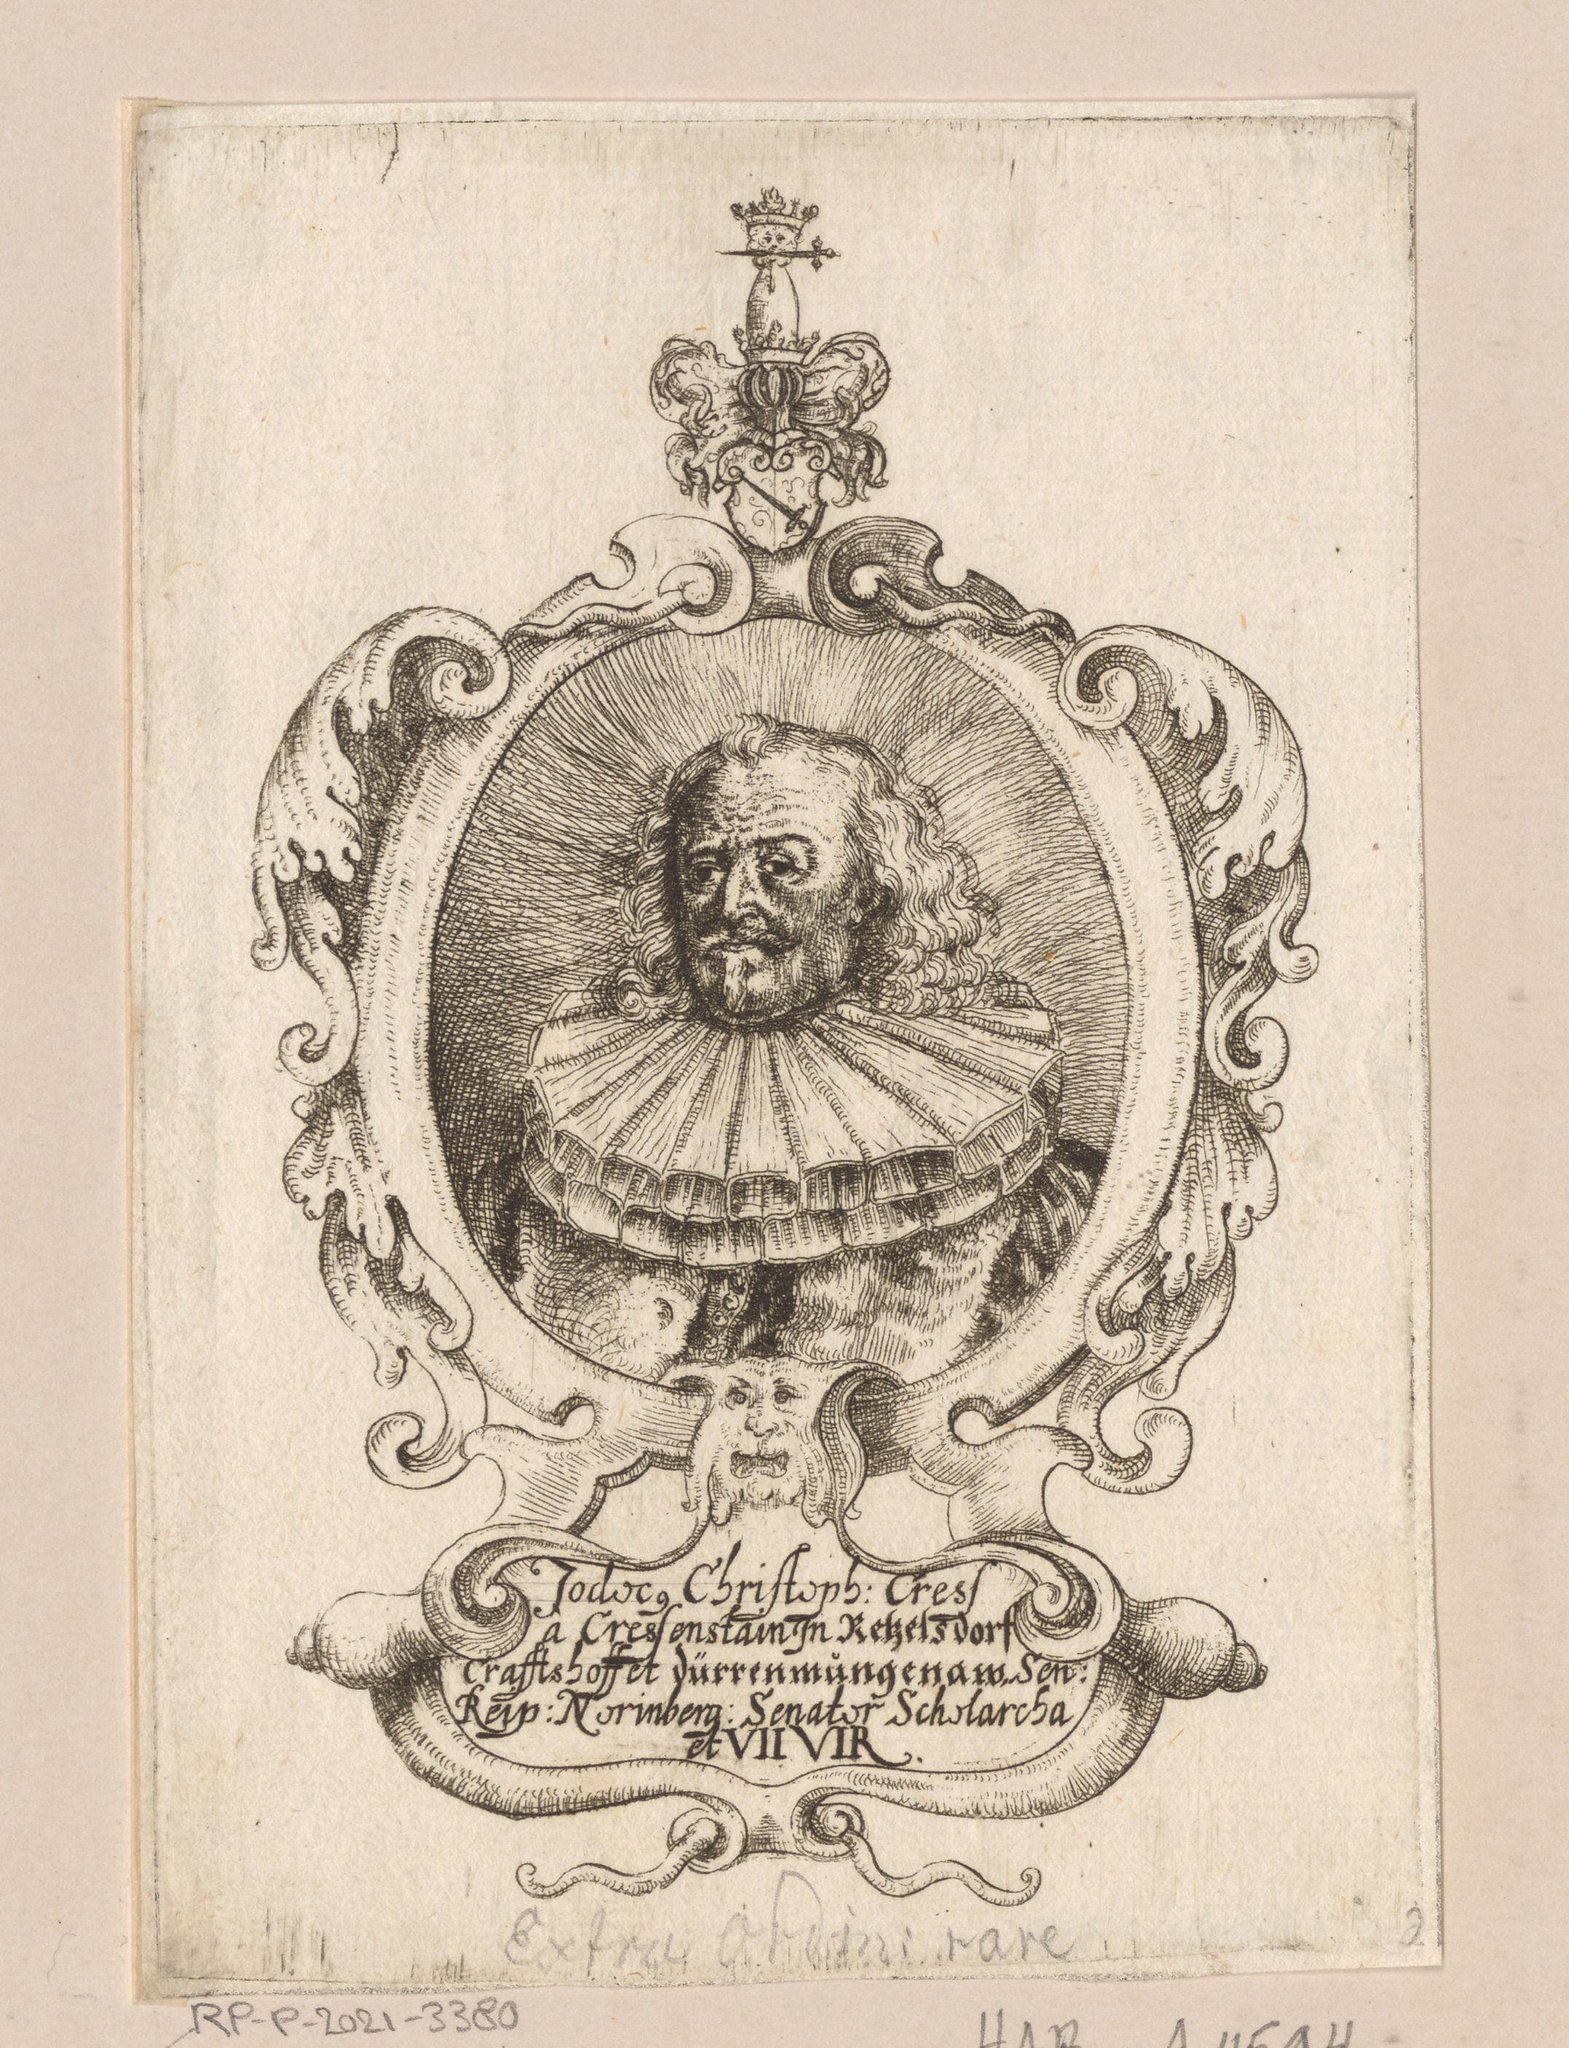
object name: print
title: Portret van Jobst Christoph Kress von Kressenstein I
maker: andreas paul multz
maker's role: draughtsman, painter, print maker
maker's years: 1643-1695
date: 1627-1699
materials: paper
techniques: etching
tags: historical persons, armorial bearing, heraldry